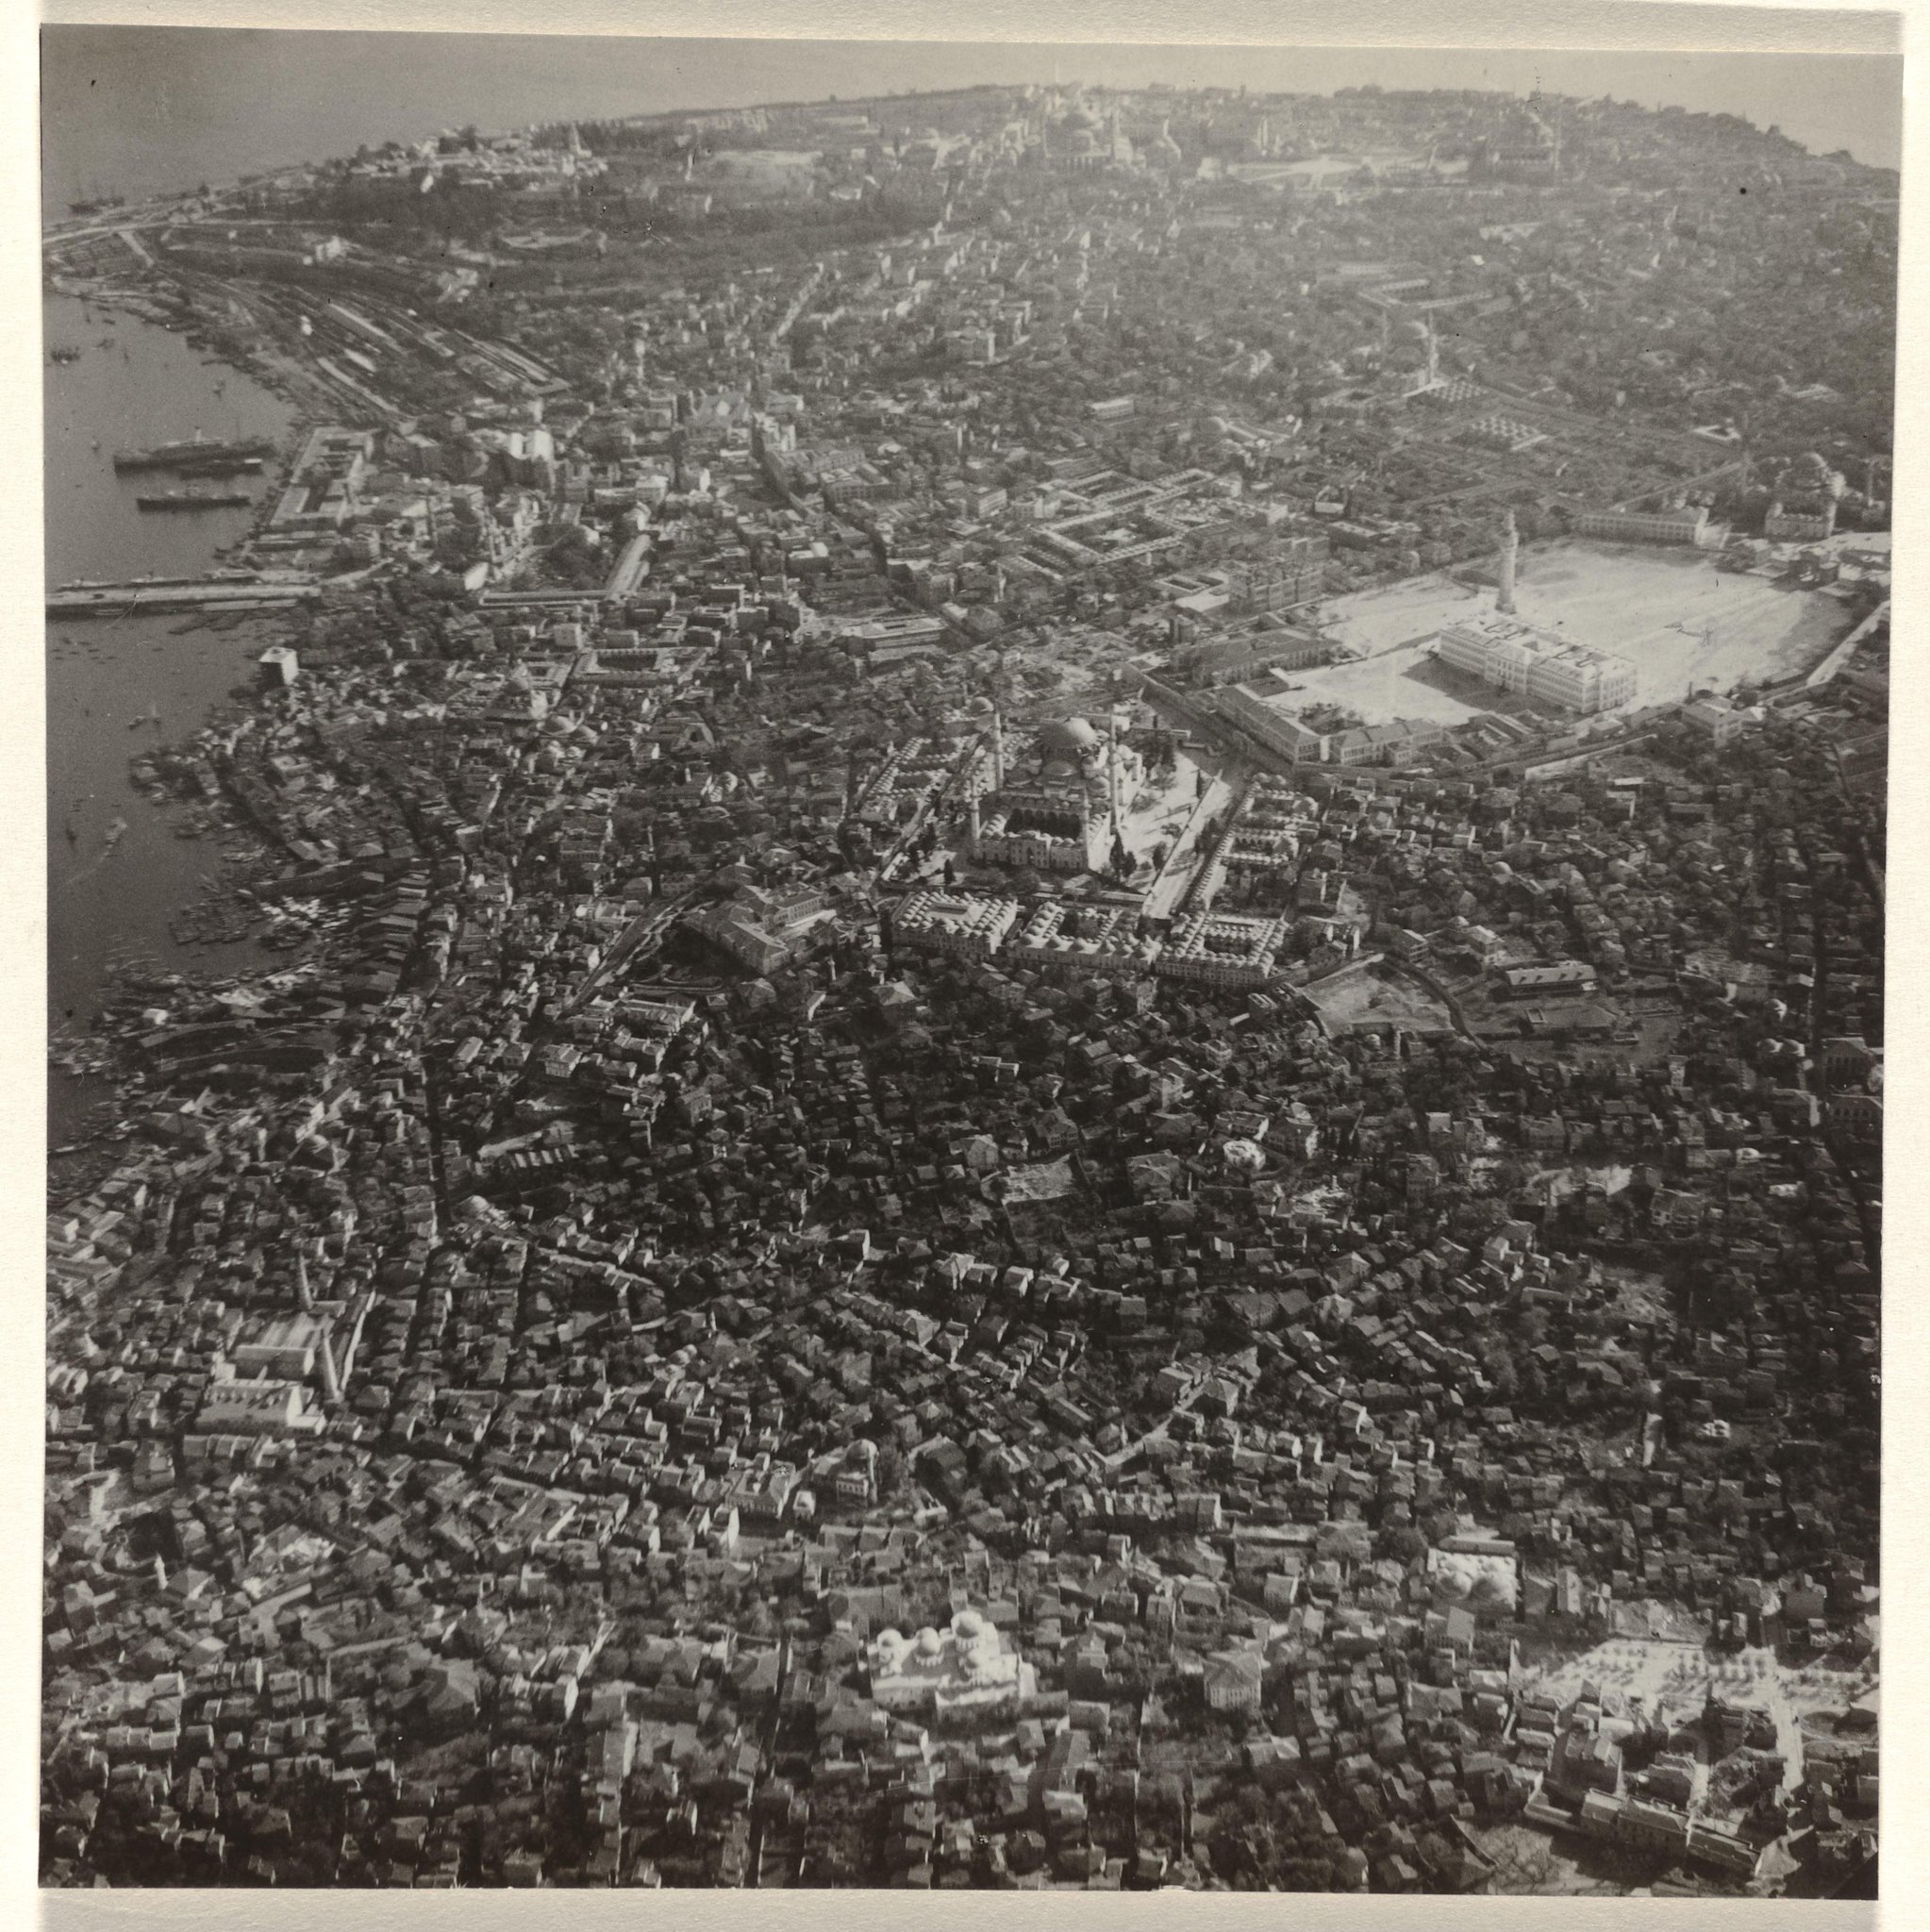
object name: photograph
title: Luchtfoto van Istanbul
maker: Anonymous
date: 1930-1975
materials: photographic support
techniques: gelatin silver print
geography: istanbul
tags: istanboel